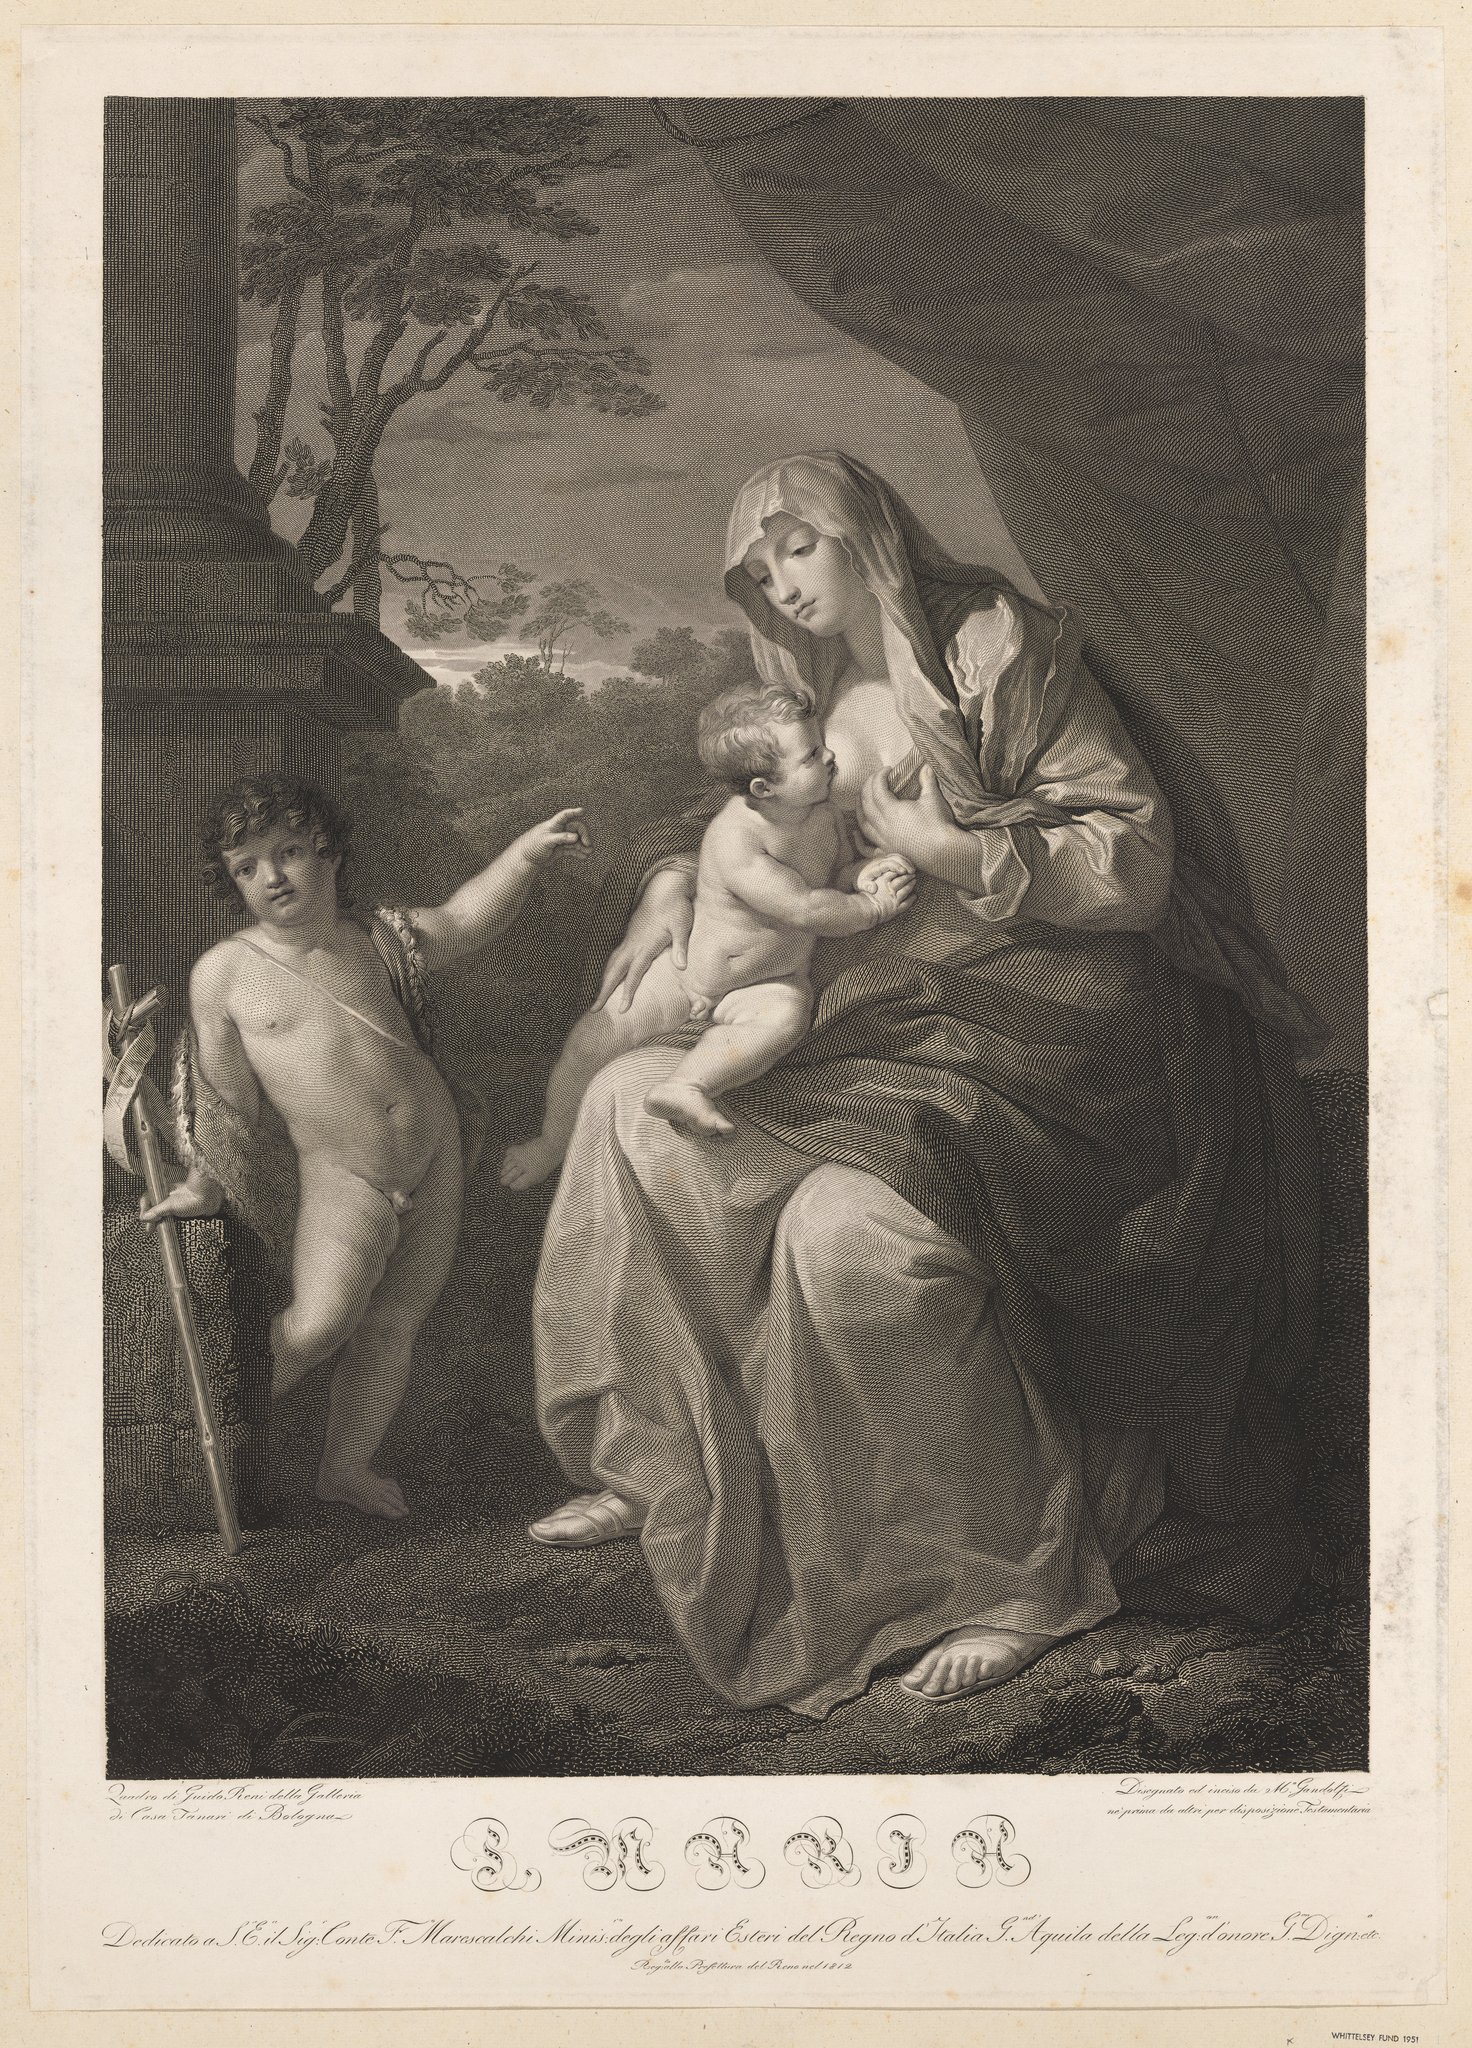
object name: print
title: The Virgin suckling the infant Christ, the young Saint John the Baptist standing at left, after Reni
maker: mauro gandolfi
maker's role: artist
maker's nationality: italian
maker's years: 1764-1834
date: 1812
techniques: engraving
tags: christ,saint john the baptist,virgin mary